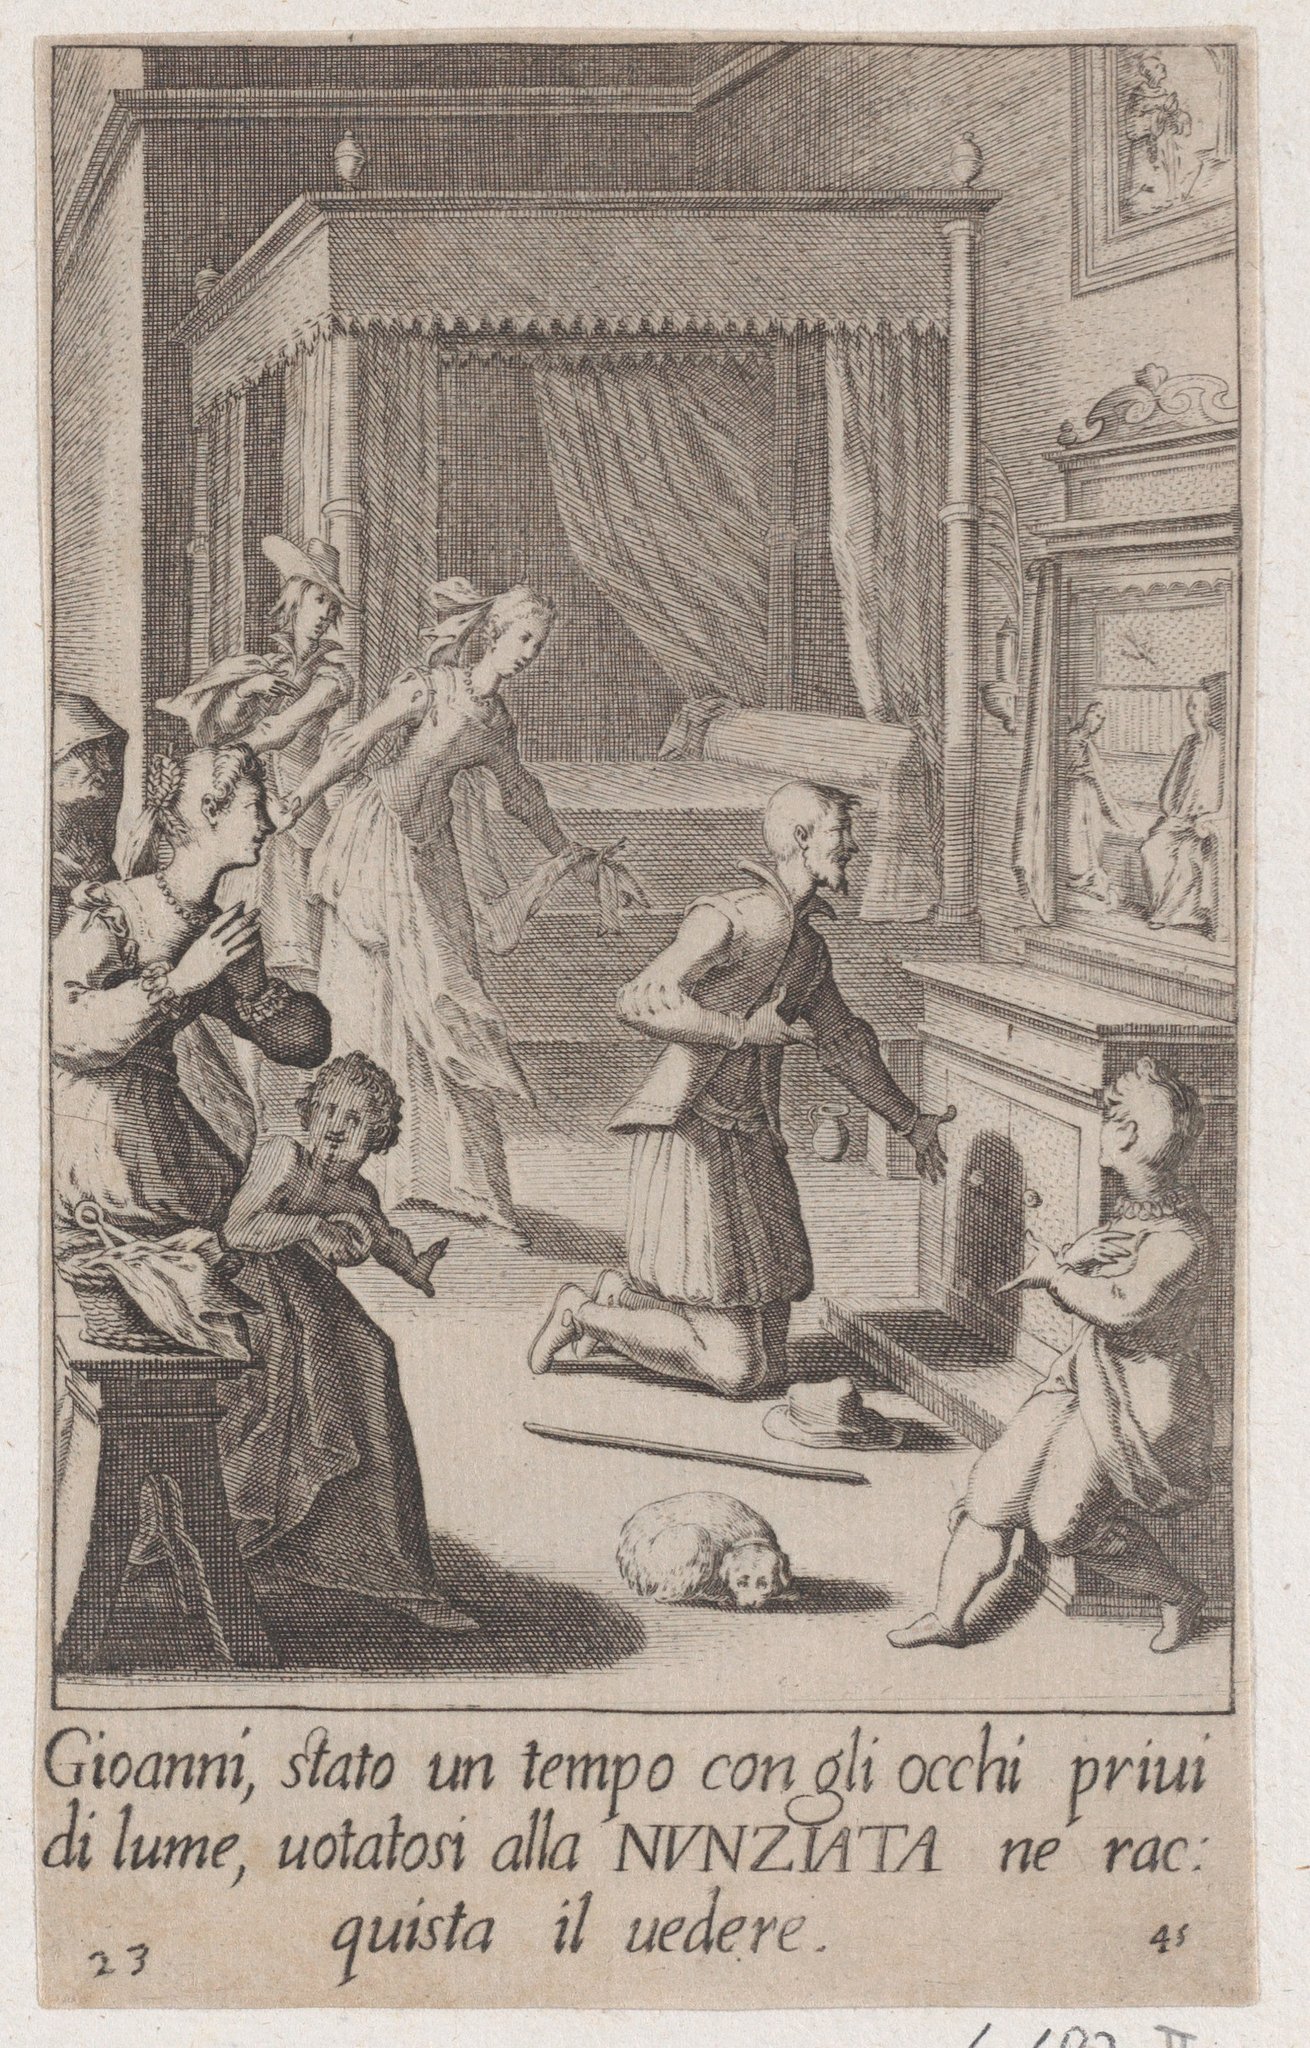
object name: print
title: Gioanni, from Scelta d'Alcuni Miracoli e Grazie della Santissima Nunziata di Firenze (Selection of Some Miracles and Graces that Occurred in the Church of the Annunziata in Florence)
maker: jacques callot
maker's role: artist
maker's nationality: french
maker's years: 1592-1635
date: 1611-1619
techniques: engraving